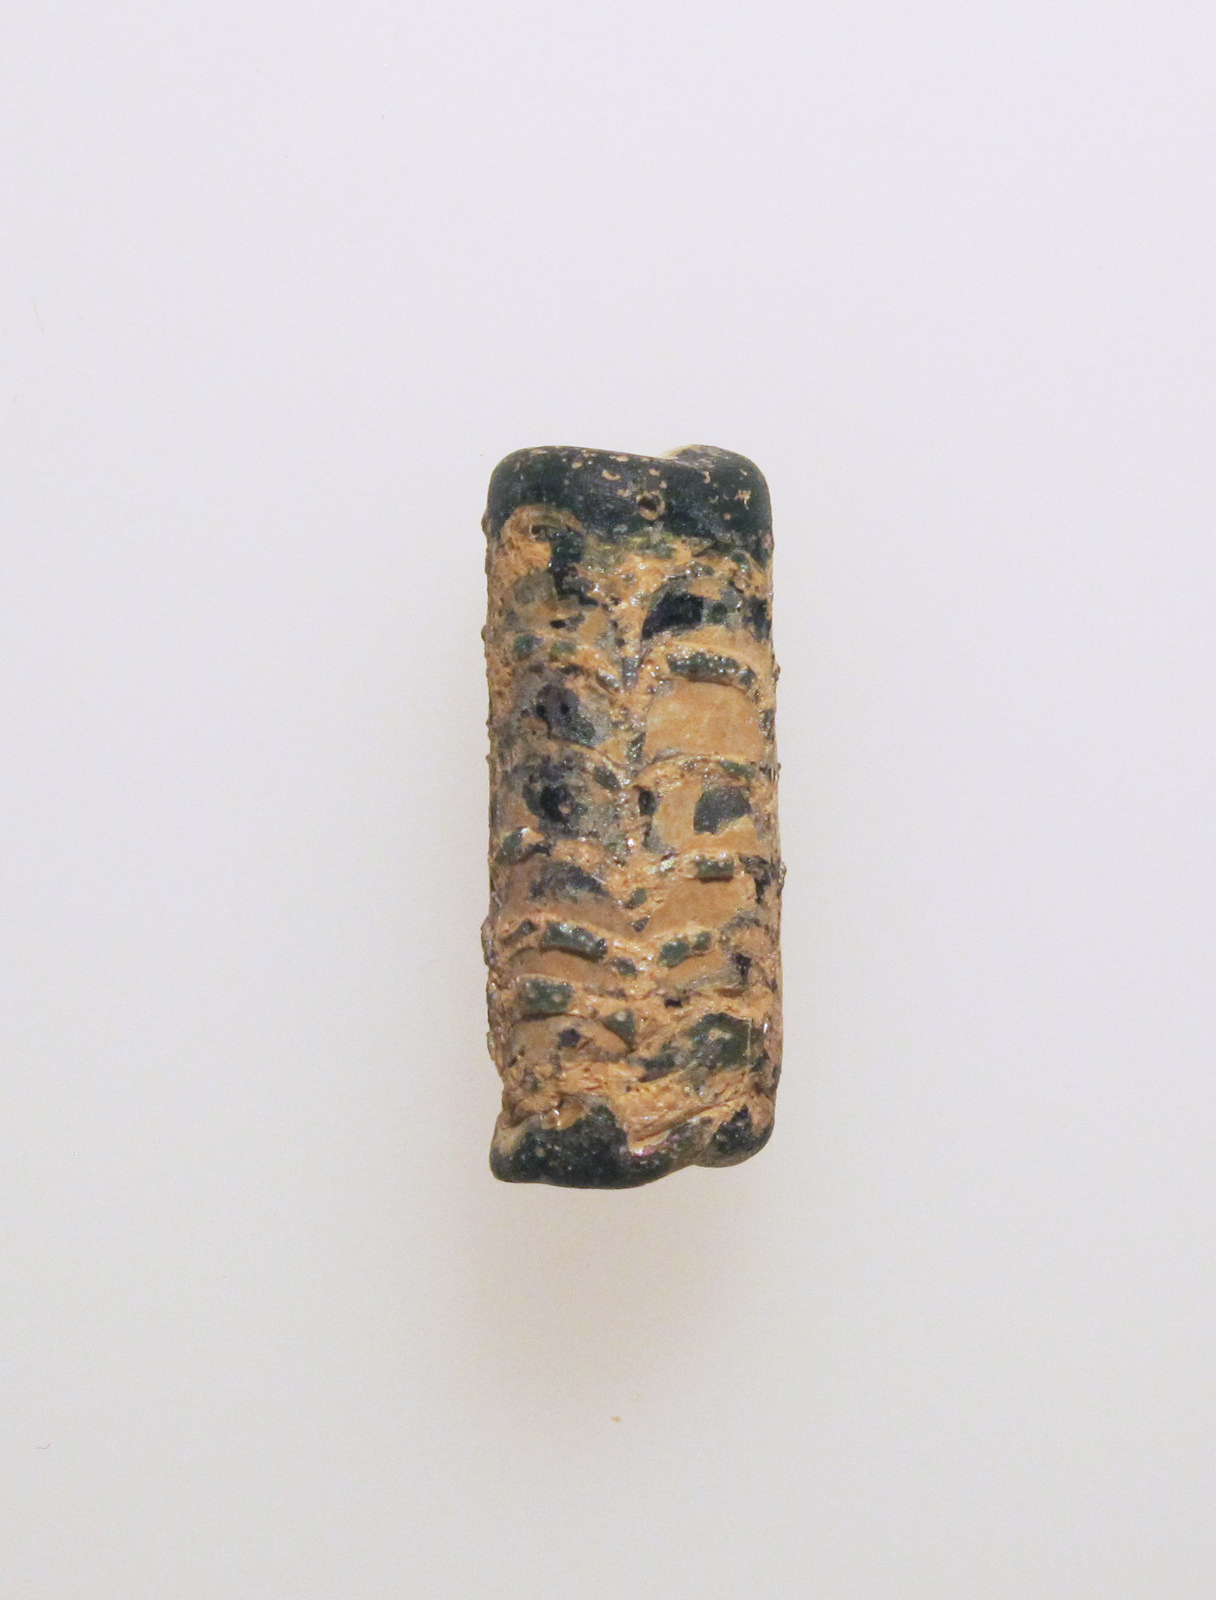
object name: bead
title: Glass bead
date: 7000 BCE-330 CE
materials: glass